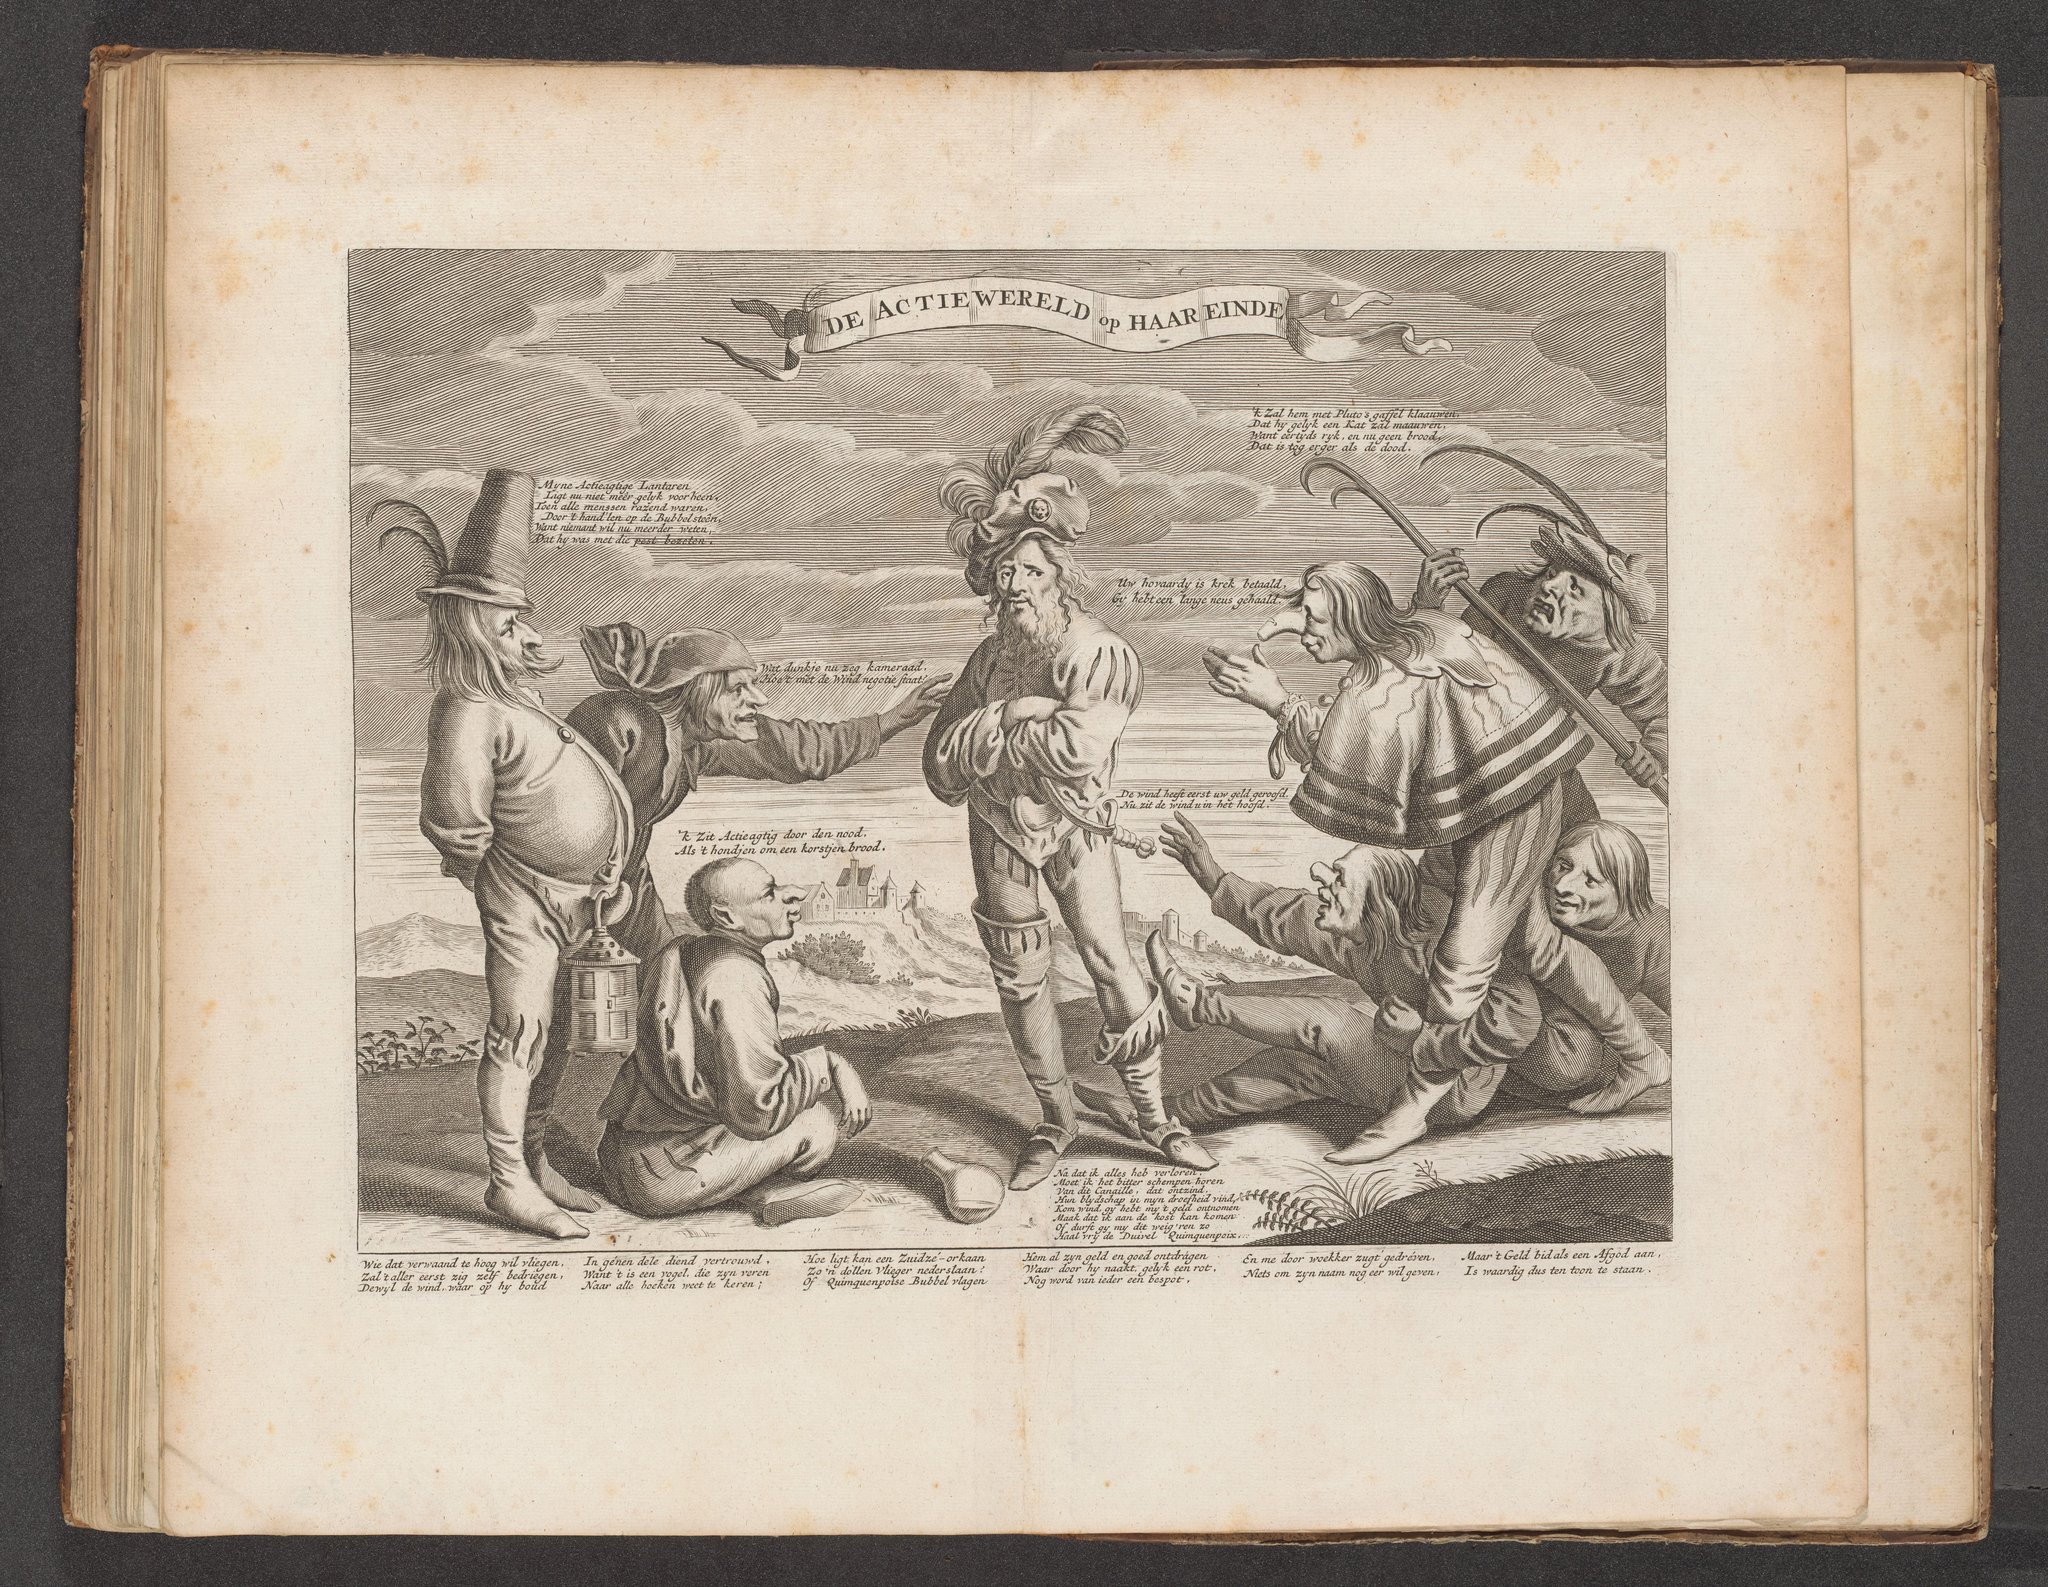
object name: print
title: Het Groote Tafereel der Dwaasheid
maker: monogrammist cl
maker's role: print maker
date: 1625-1650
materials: paper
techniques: engraving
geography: northern netherlands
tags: diogenes, carrying a lighted lantarn by daylight, trying to find an honest man, usually in a crowded market-place, mocking, insulting; teasing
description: De Actiewereld op haar einde. Een windhandelaar die alles heeft verloren wordt door dwazen beschimpt en uitgelachen. Oorspronkelijk Diogenes die met een lamp op de markt een mens zoekt. Met verschillende onderschriften. Prent in de gebonden vierde uitgave (304 B 12) van Het Groote Tafereel der Dwaasheid met spotprenten op de Windhandel of Actiehandel van 1720.